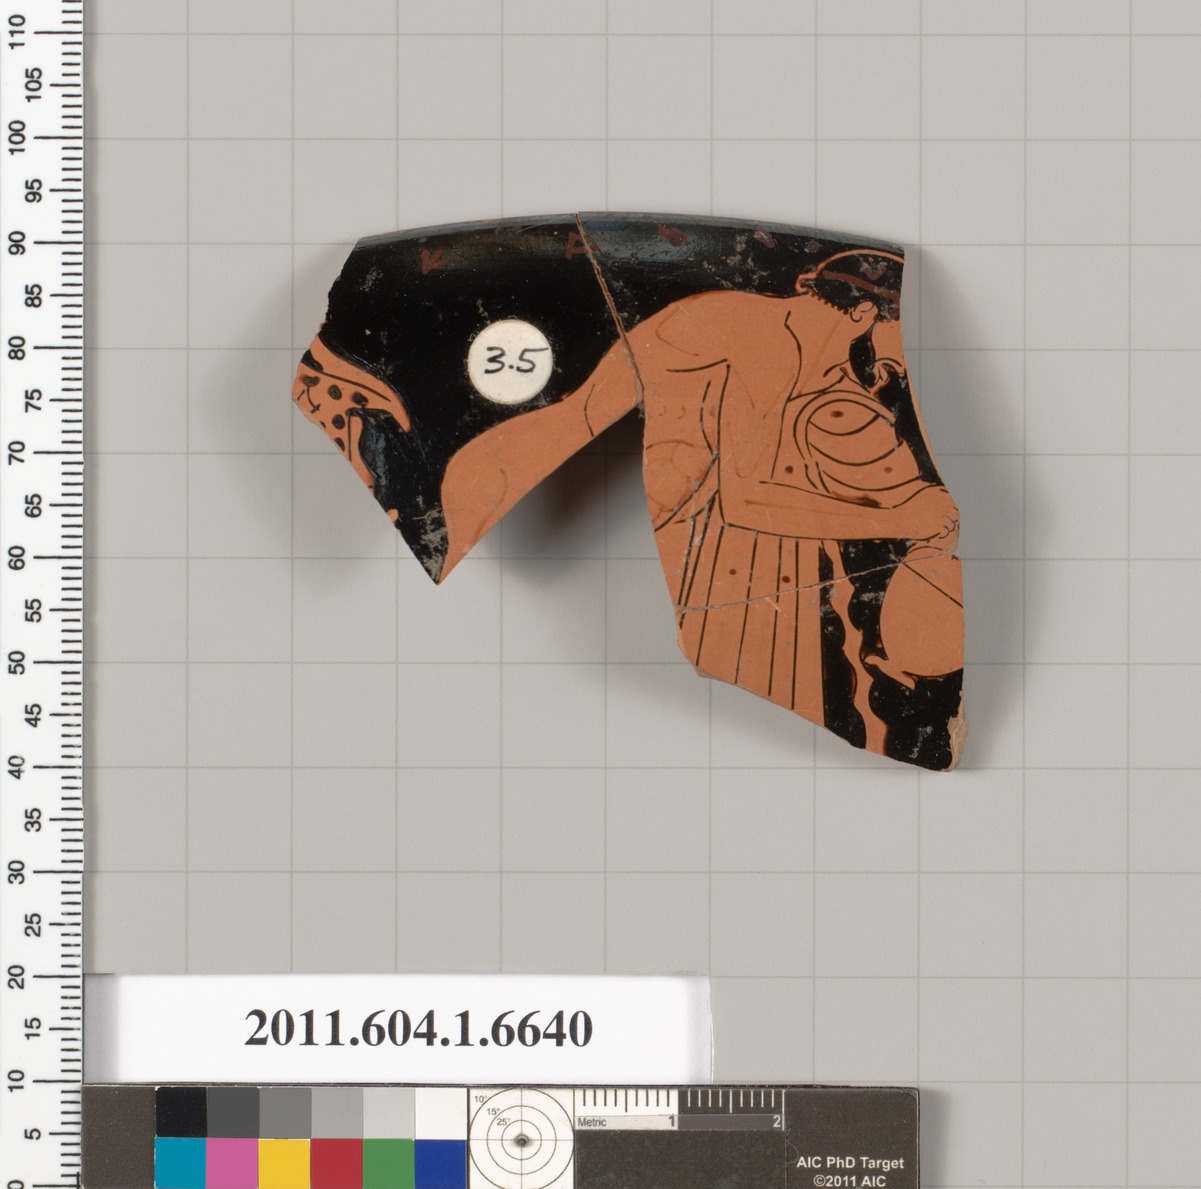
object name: kylix fragment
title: Terracotta rim fragment of a kylix (drinking cup)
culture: greek, attic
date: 490-470 BCE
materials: terracotta